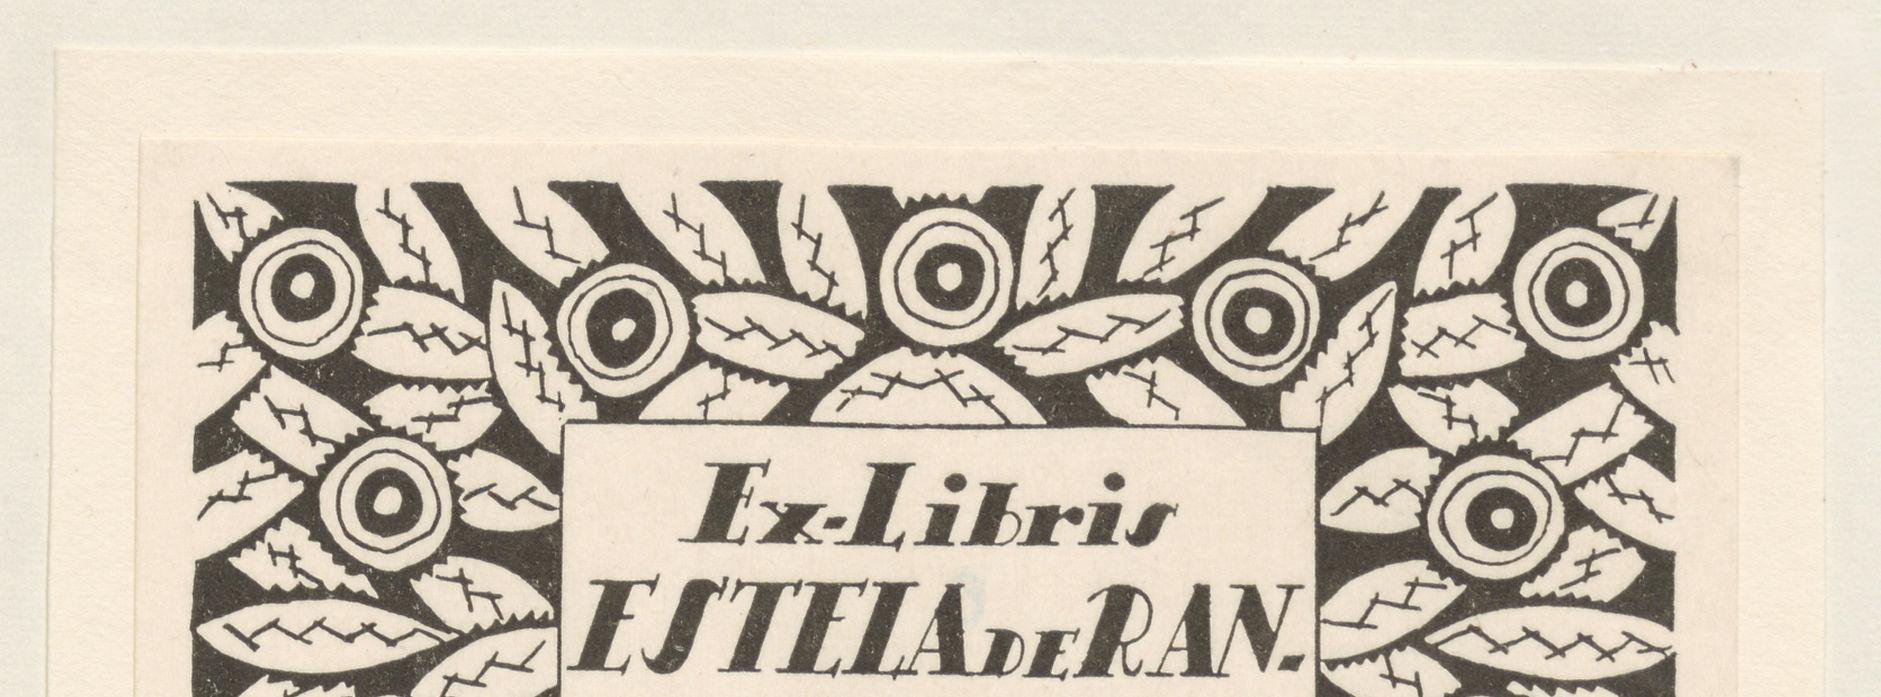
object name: bookplate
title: Ex libris van Estela de Rangel G. Pereira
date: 1900-1999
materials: paper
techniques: printing block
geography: portugal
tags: foliage ~ ornament - aa - stylized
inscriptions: workshop stamp: ‘6 / ipse fecit’